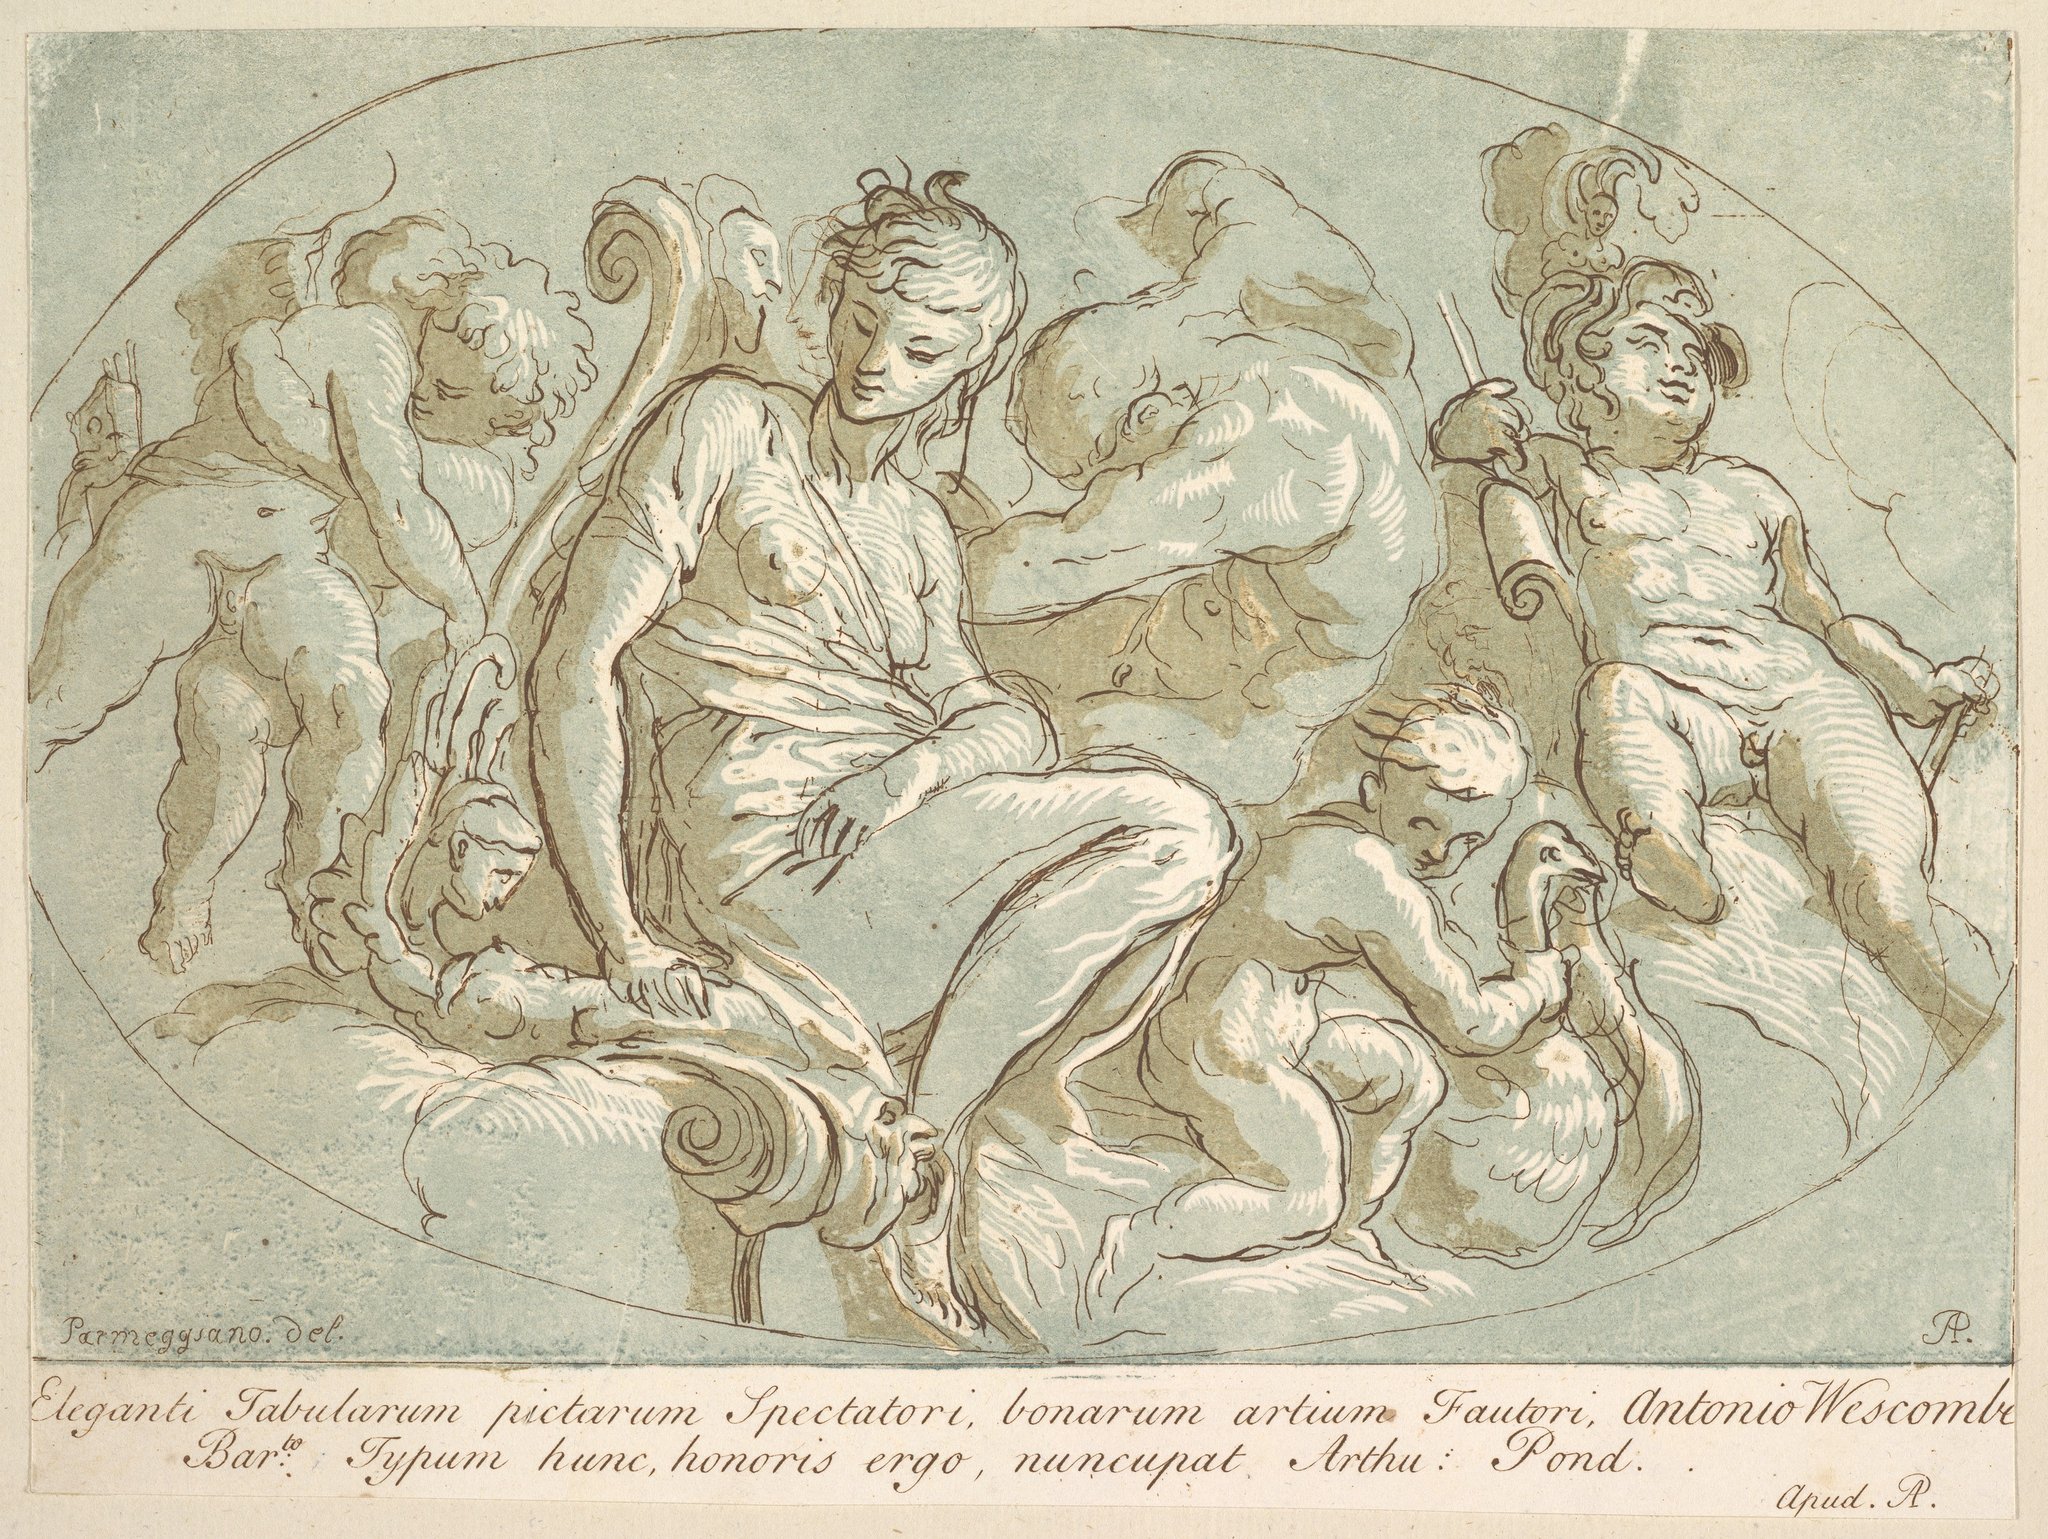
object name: print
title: Venus Surrounded by Putti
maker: arthur pond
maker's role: artist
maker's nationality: british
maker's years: 1701-1758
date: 1735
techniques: aquatint, etching, woodcut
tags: putti,venus